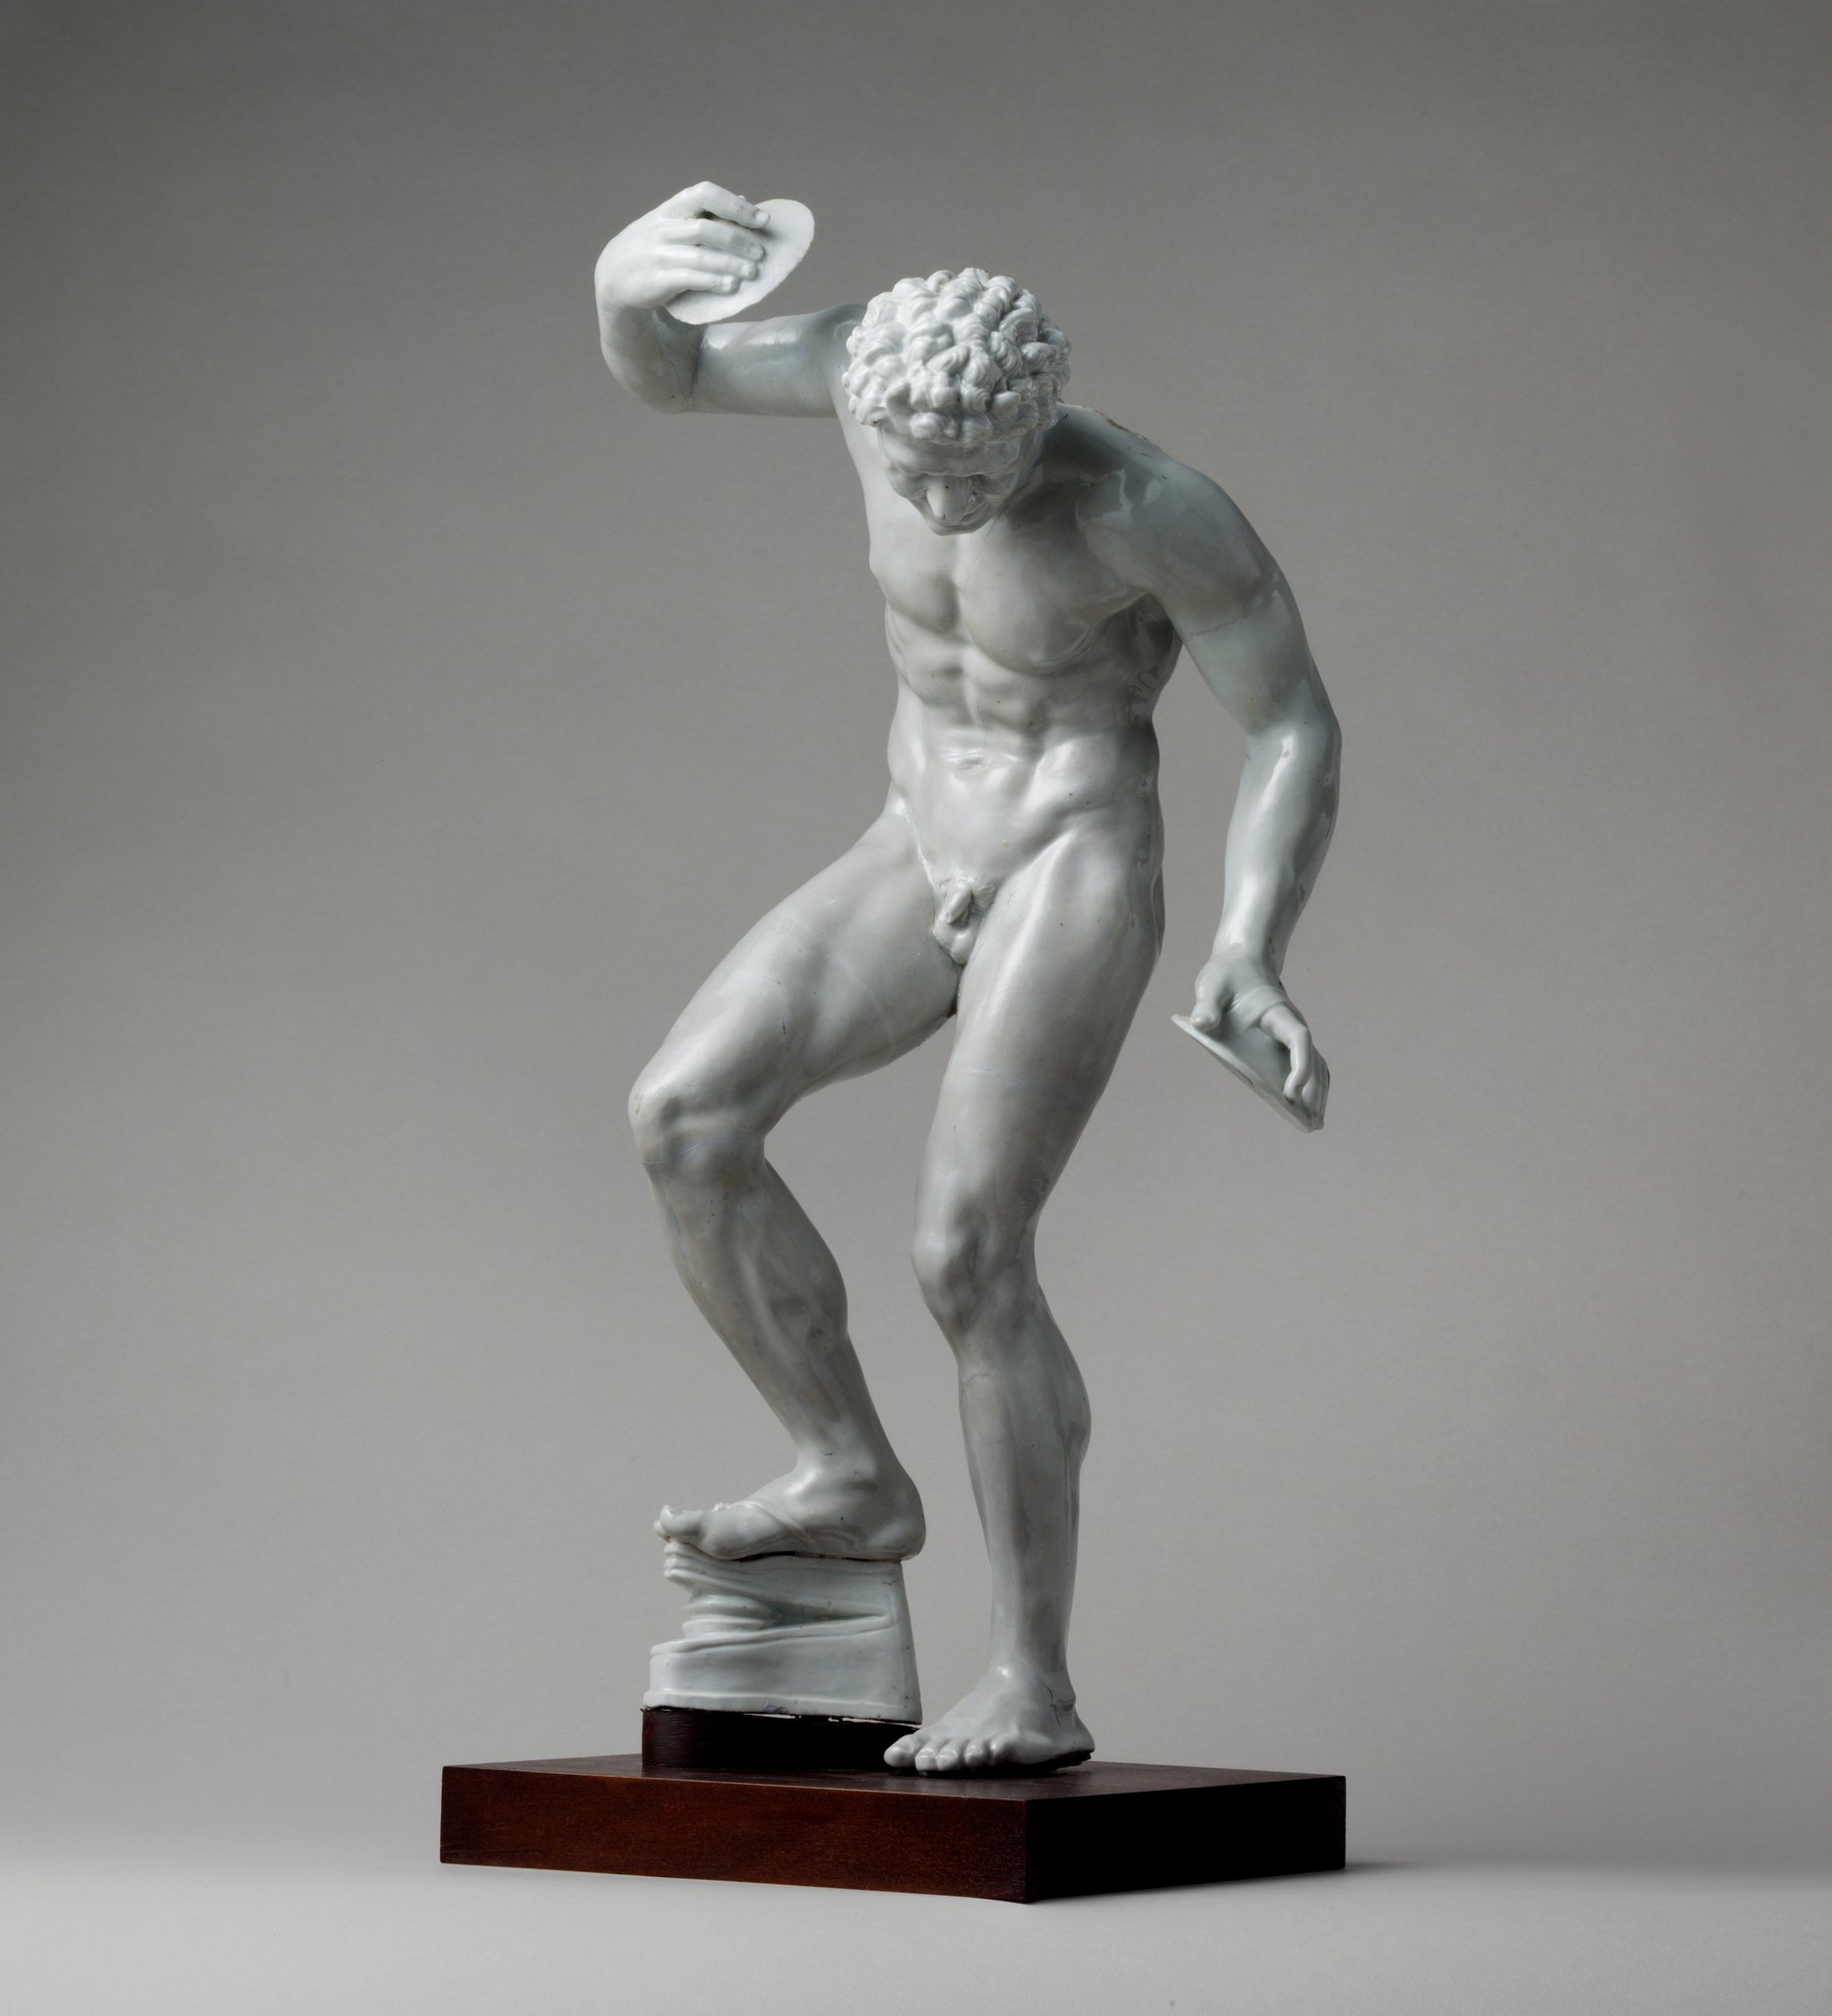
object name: figure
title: Dancing Faun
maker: doccia porcelain manufactory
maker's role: manufactory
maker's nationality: italian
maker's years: 1737-1896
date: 1750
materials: hard paste porcelain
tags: dancing,fauns